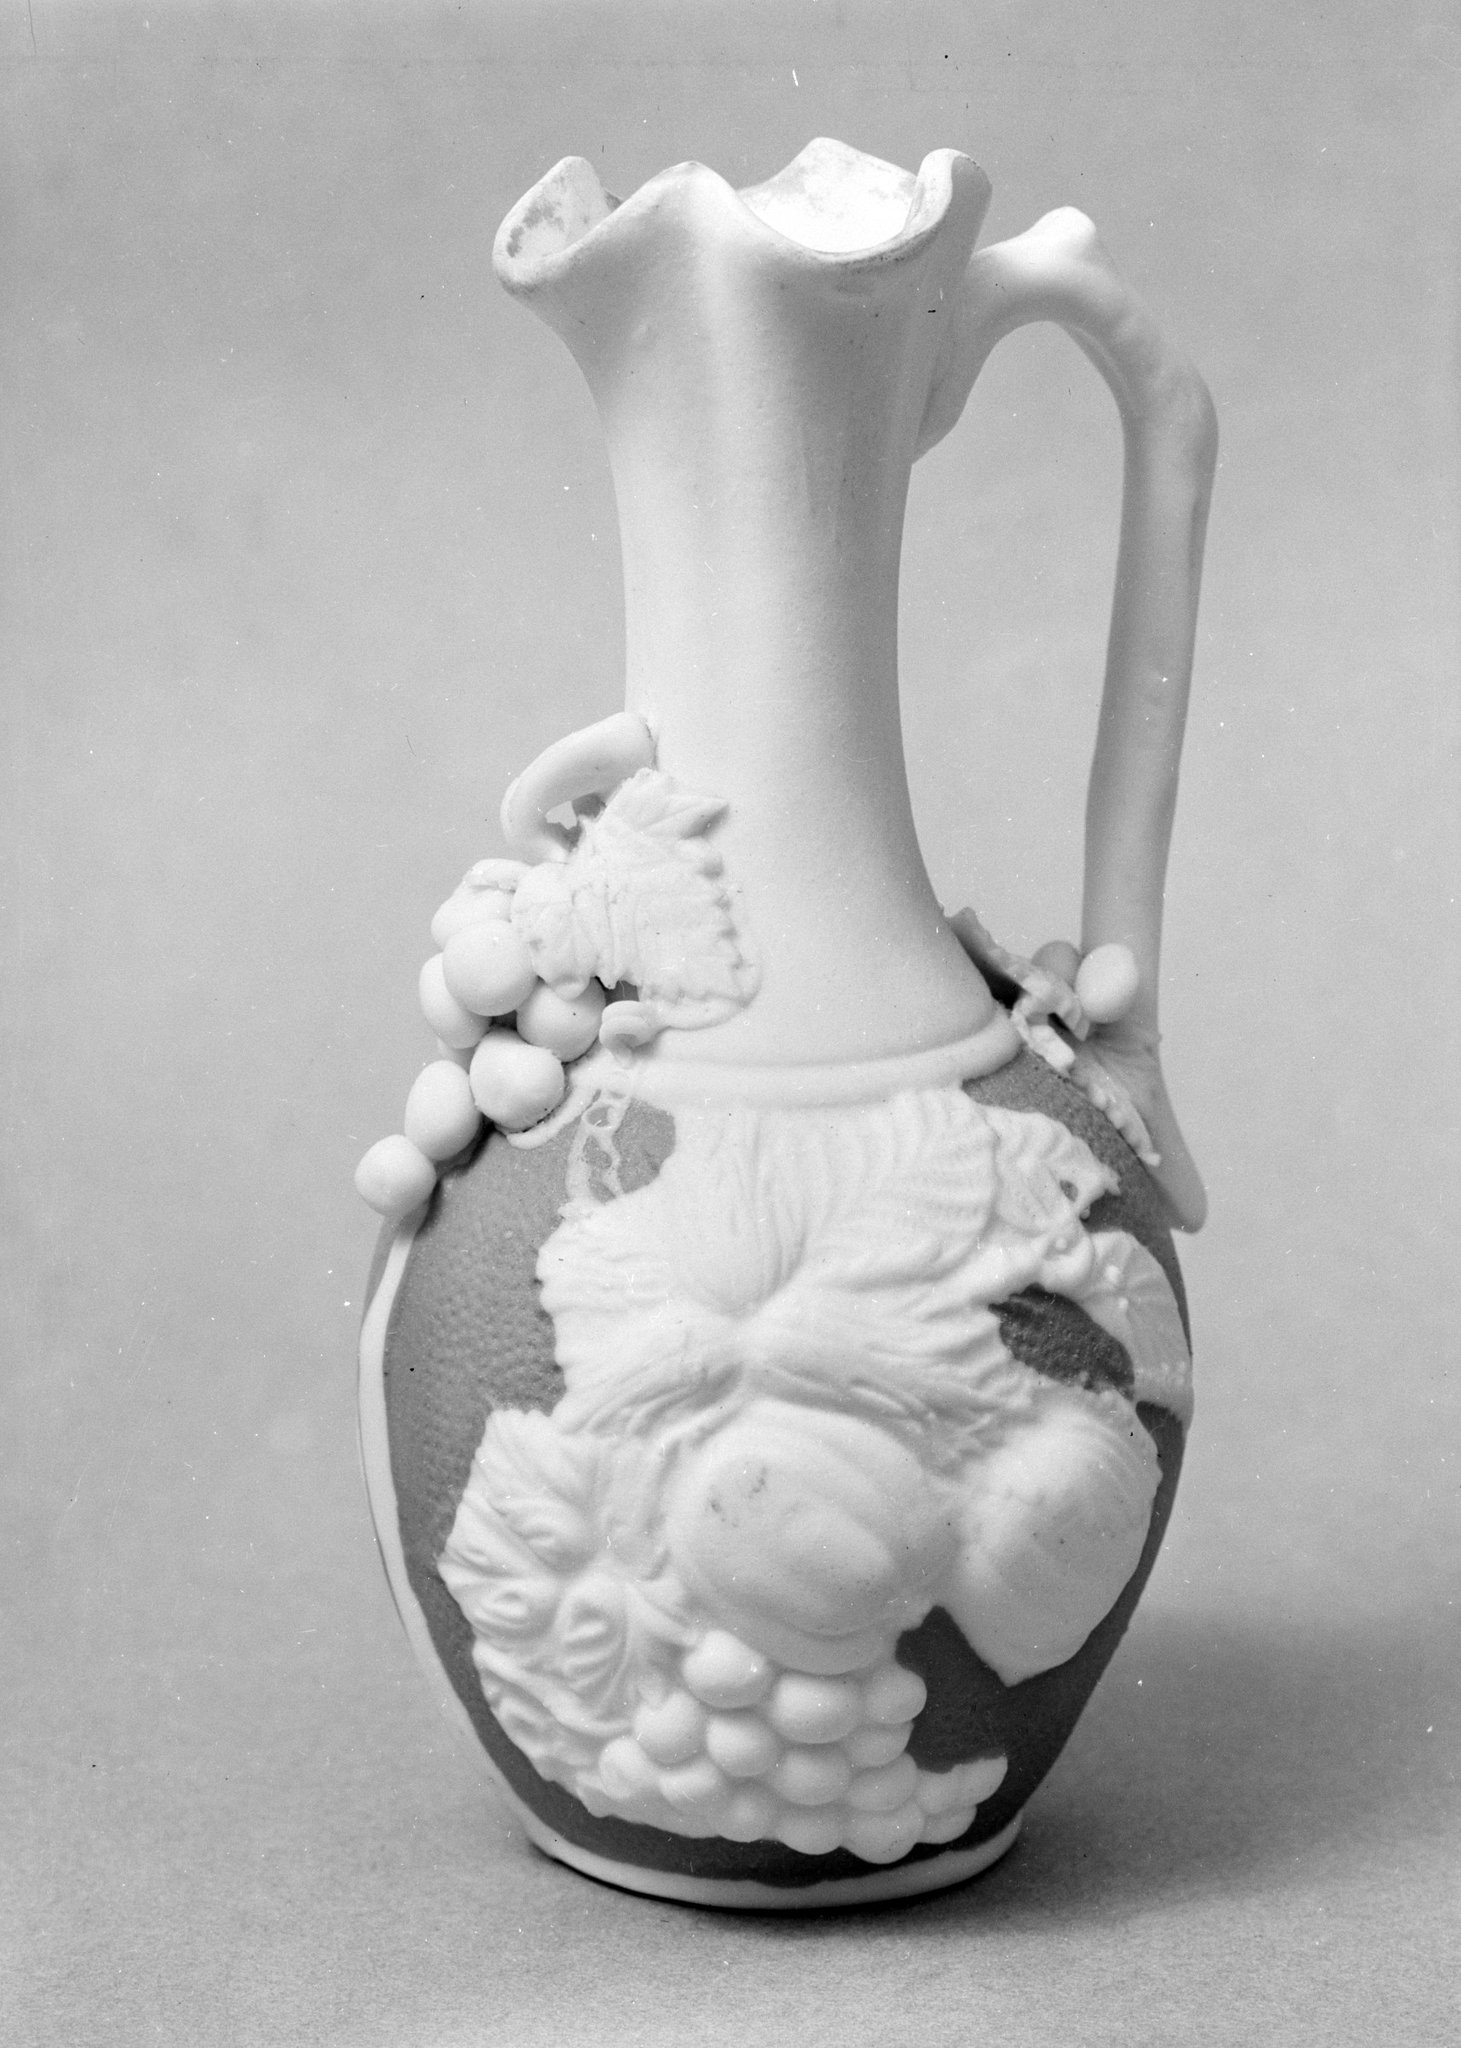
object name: ewer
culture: american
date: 1830-1870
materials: porcelain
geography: united states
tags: fruit